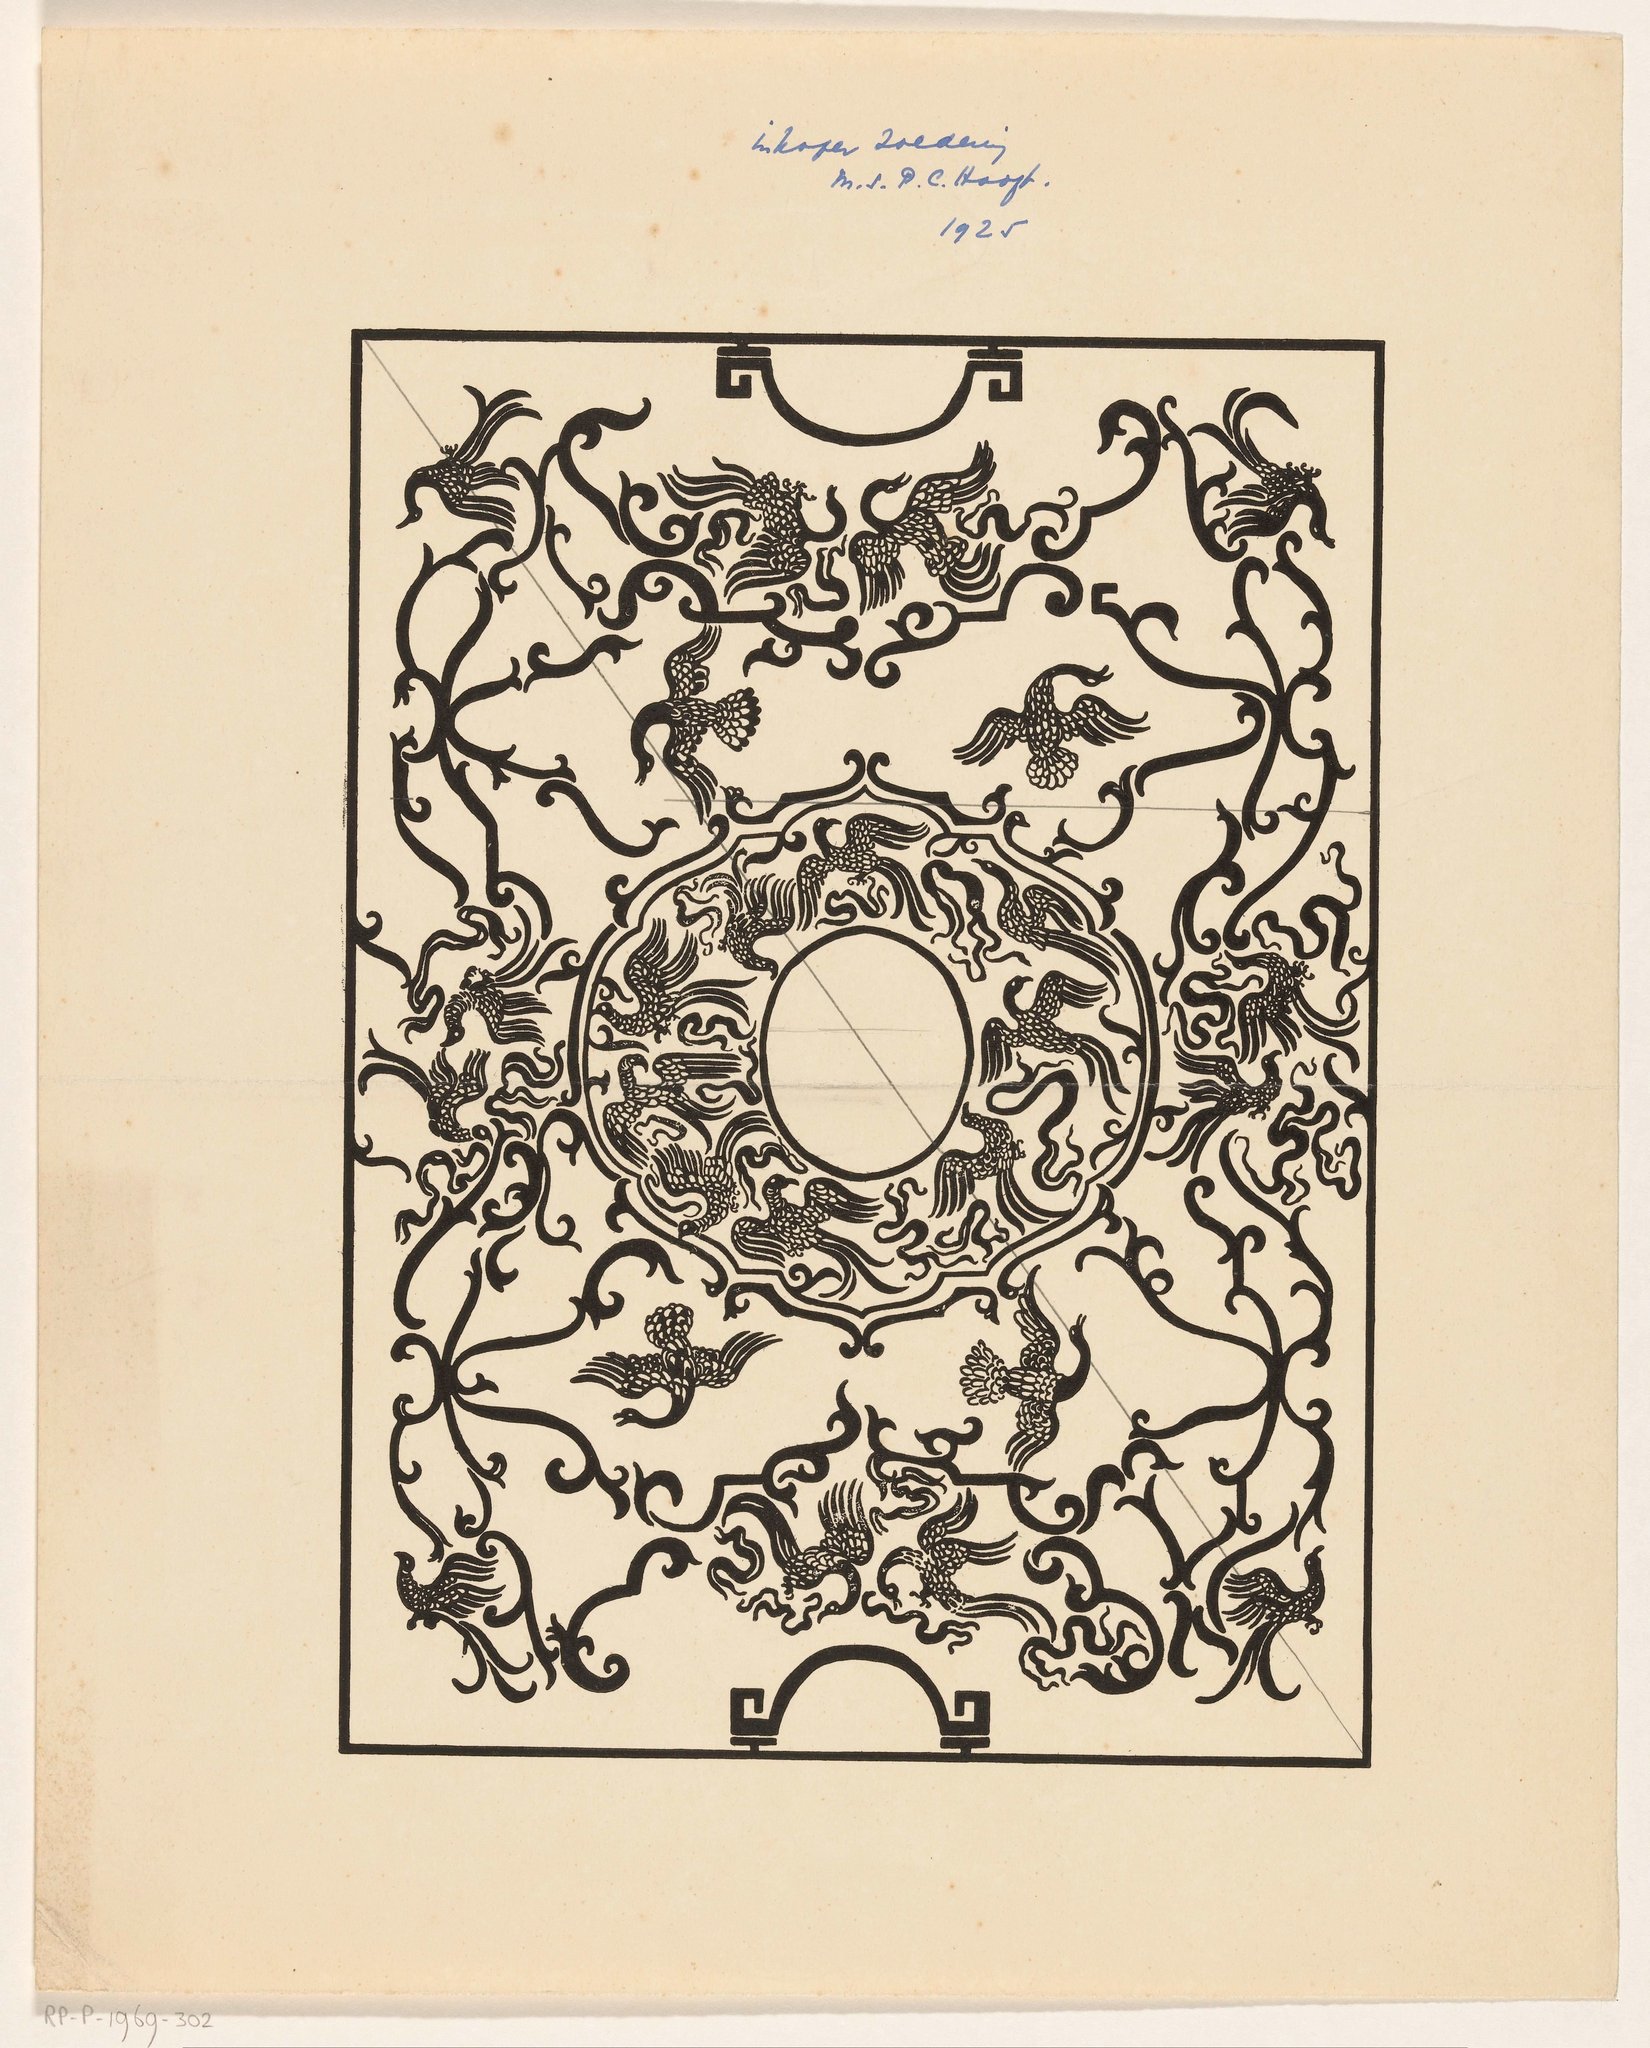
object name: study for binding design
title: Bandontwerp voor: L'art hollandais à l'exposition internationale des arts décoratifs et industriels modernes, 1925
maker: carel adolph lion cachet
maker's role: draughtsman, print maker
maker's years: 1864-1945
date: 1925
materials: paper, pencil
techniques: printing block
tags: ornament derived from animal forms, birds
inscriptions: annotation: ‘in koper zoldering M.s. P.C. Hooft. 1925’, collector's mark: Lugt 2228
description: Prent mogelijk gebruikt voor: L'art hollandais à l'exposition internationale des arts décoratifs et industriels modernes. Haarlem: Enschedé & Zonen, 1925.